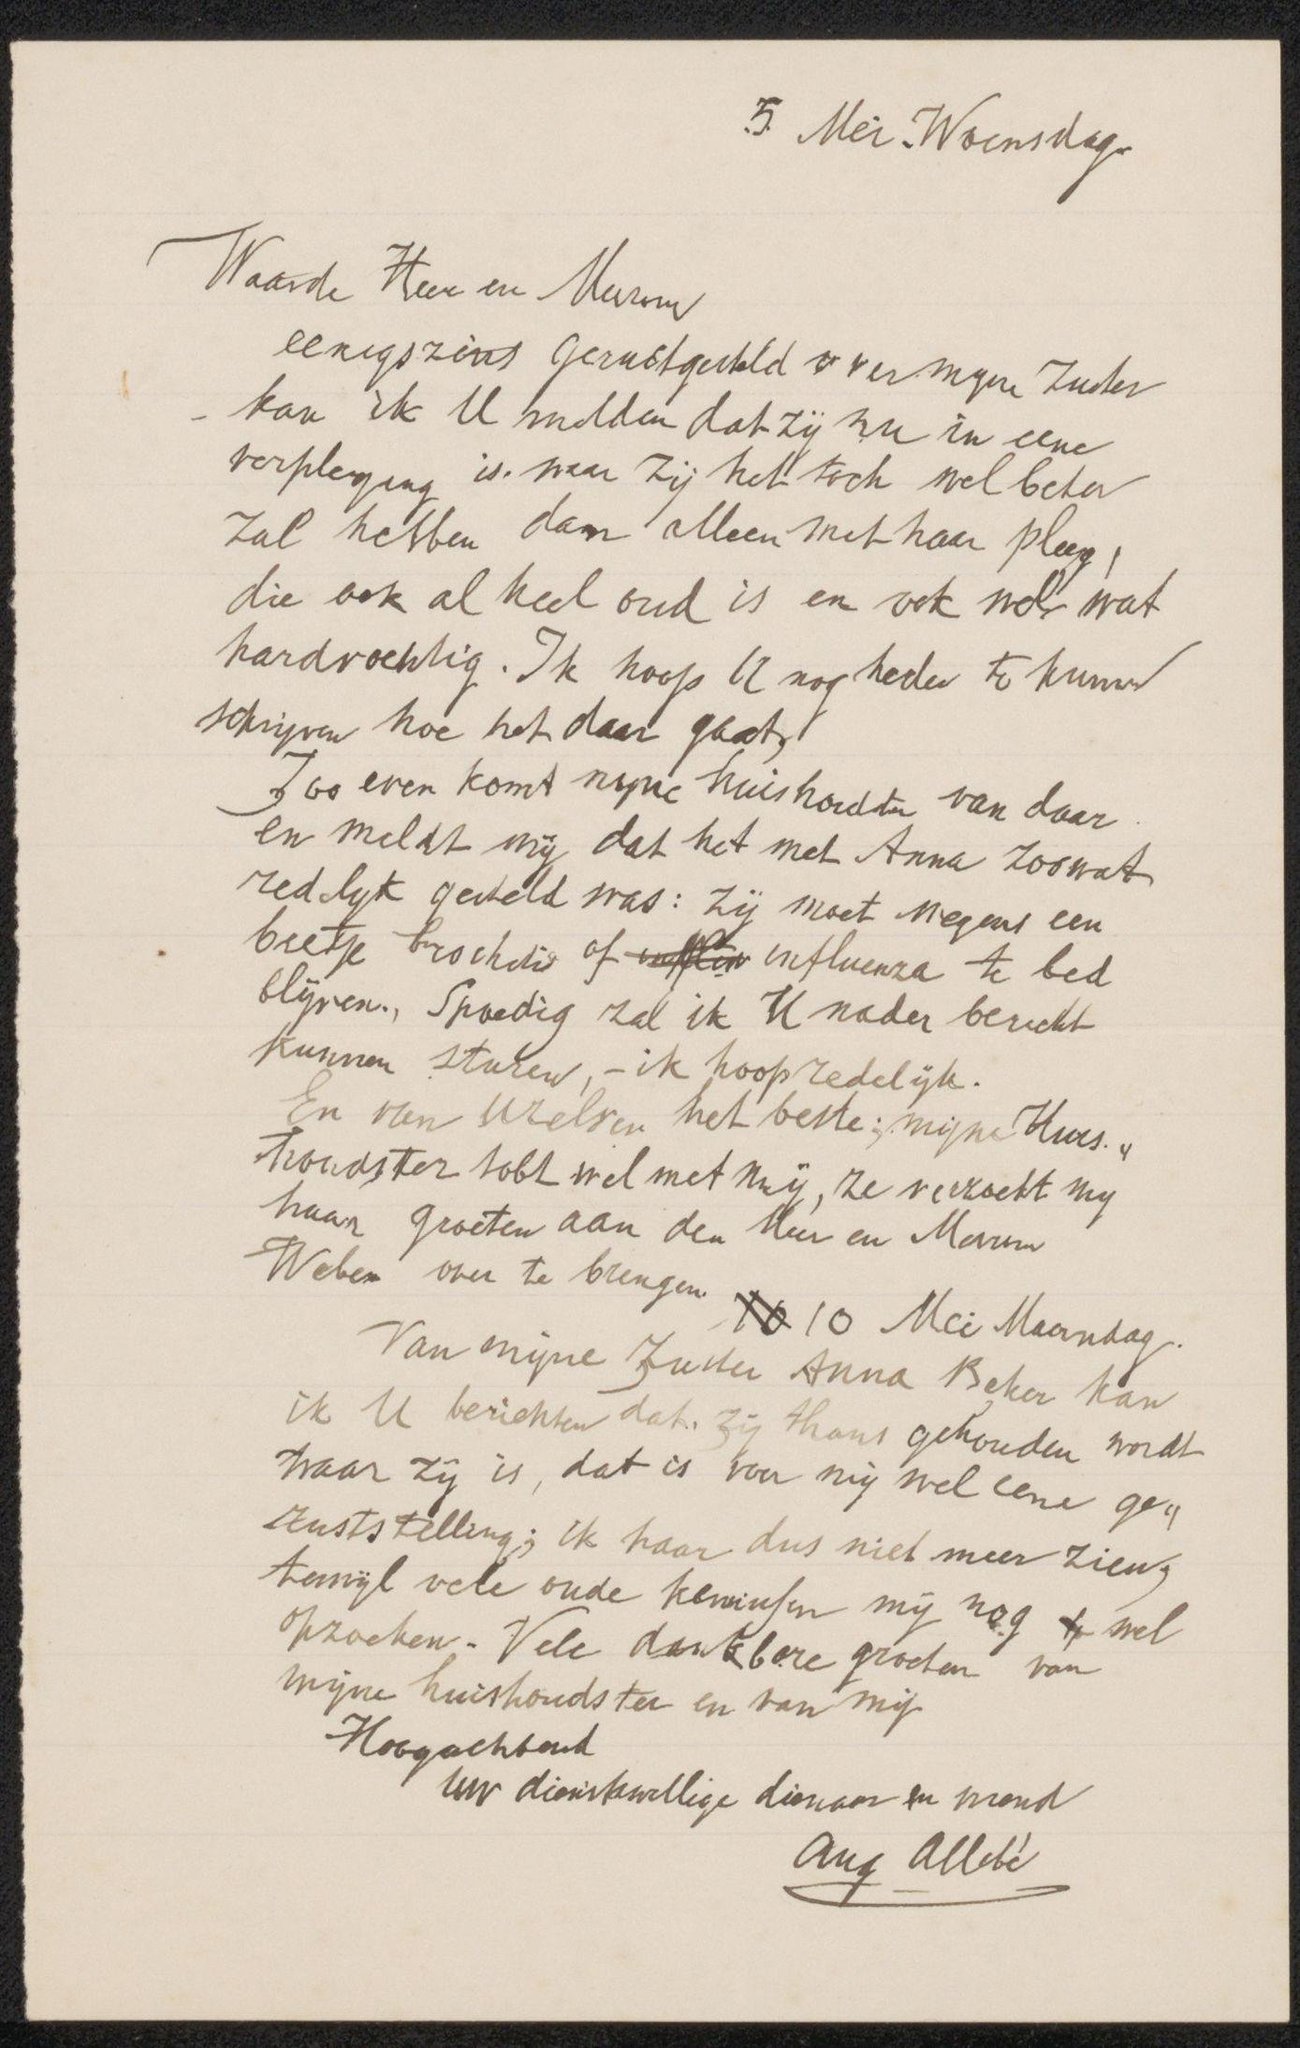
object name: letter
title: Brief aan Max Wilhelm Carl Weber en Anne Antoinette Weber-Van Bosse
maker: august allebé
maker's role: draughtsman, print maker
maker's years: 1838-1927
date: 1862-1927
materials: ink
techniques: pen, writing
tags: amsterdam, anne antoinette weber-van bosse, anna allebé, diseases